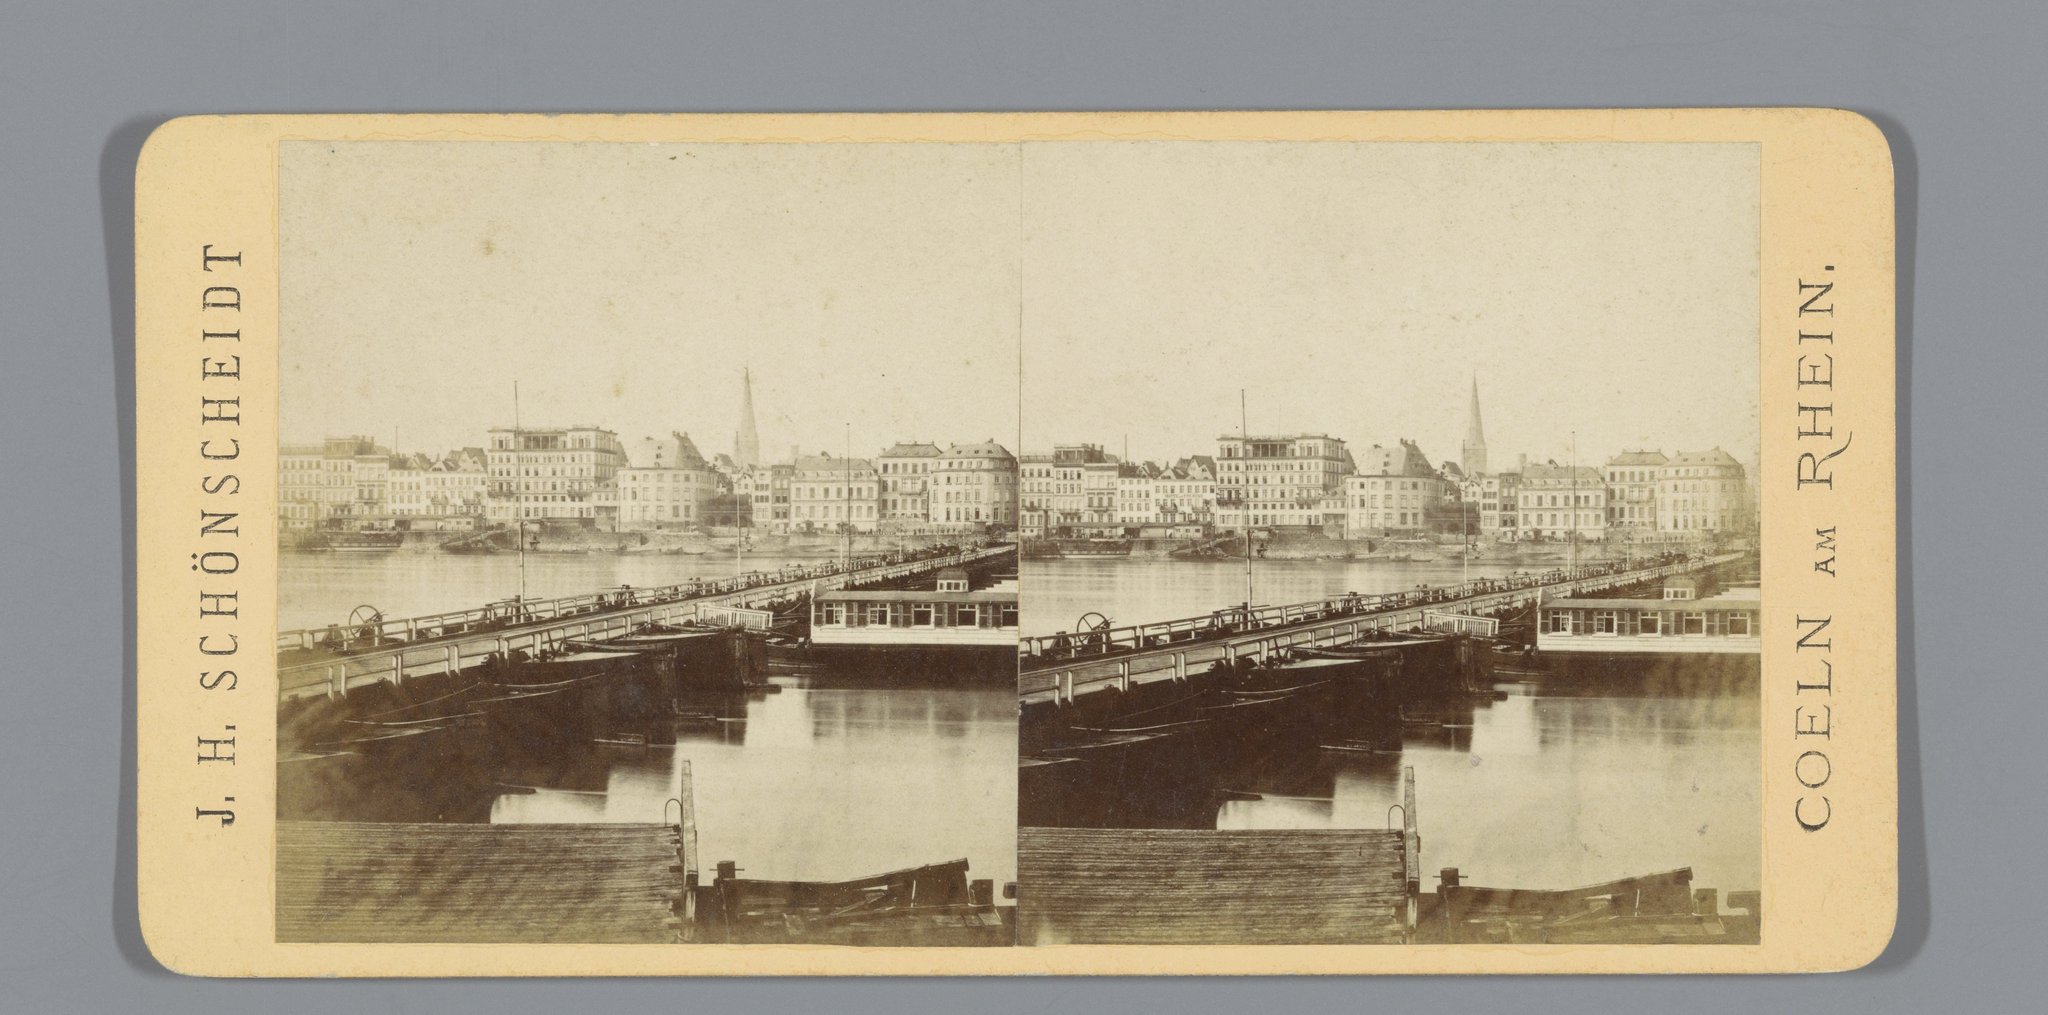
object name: stereograph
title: Coeln am Rhein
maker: johann heinrich schönscheidt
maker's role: fotograaf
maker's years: 1835-1903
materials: cardboard, photographic support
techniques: albumen print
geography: cologne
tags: river, pontoon bridge, cologne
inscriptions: inscription: ‘No 86’